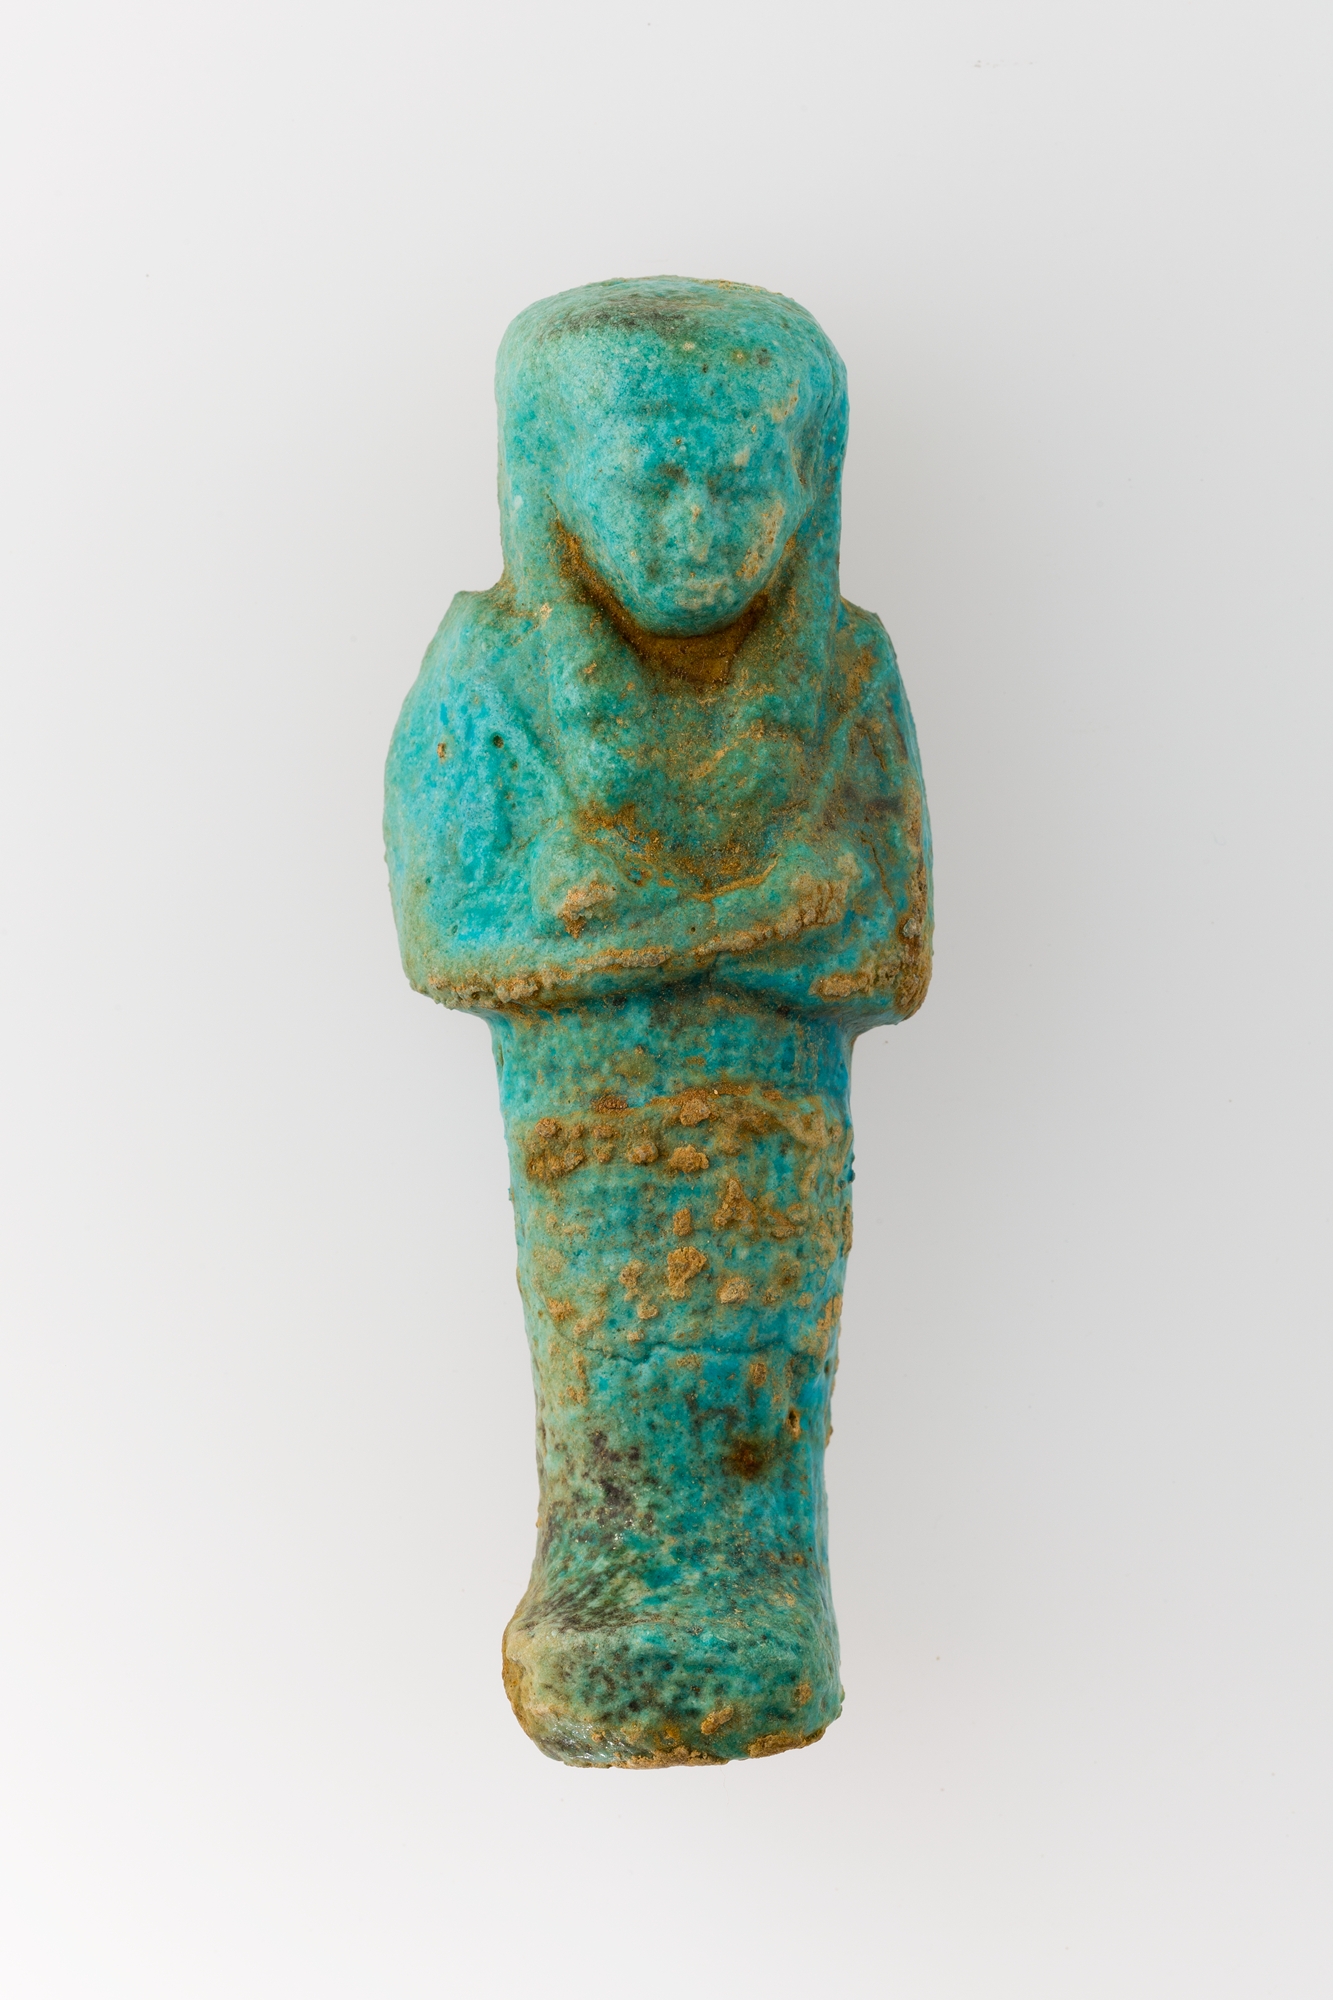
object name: shabti, henettawy c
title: Worker Shabti of Henettawy (C), Daughter of Isetemkheb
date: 990-970 BCE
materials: faience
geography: egypt